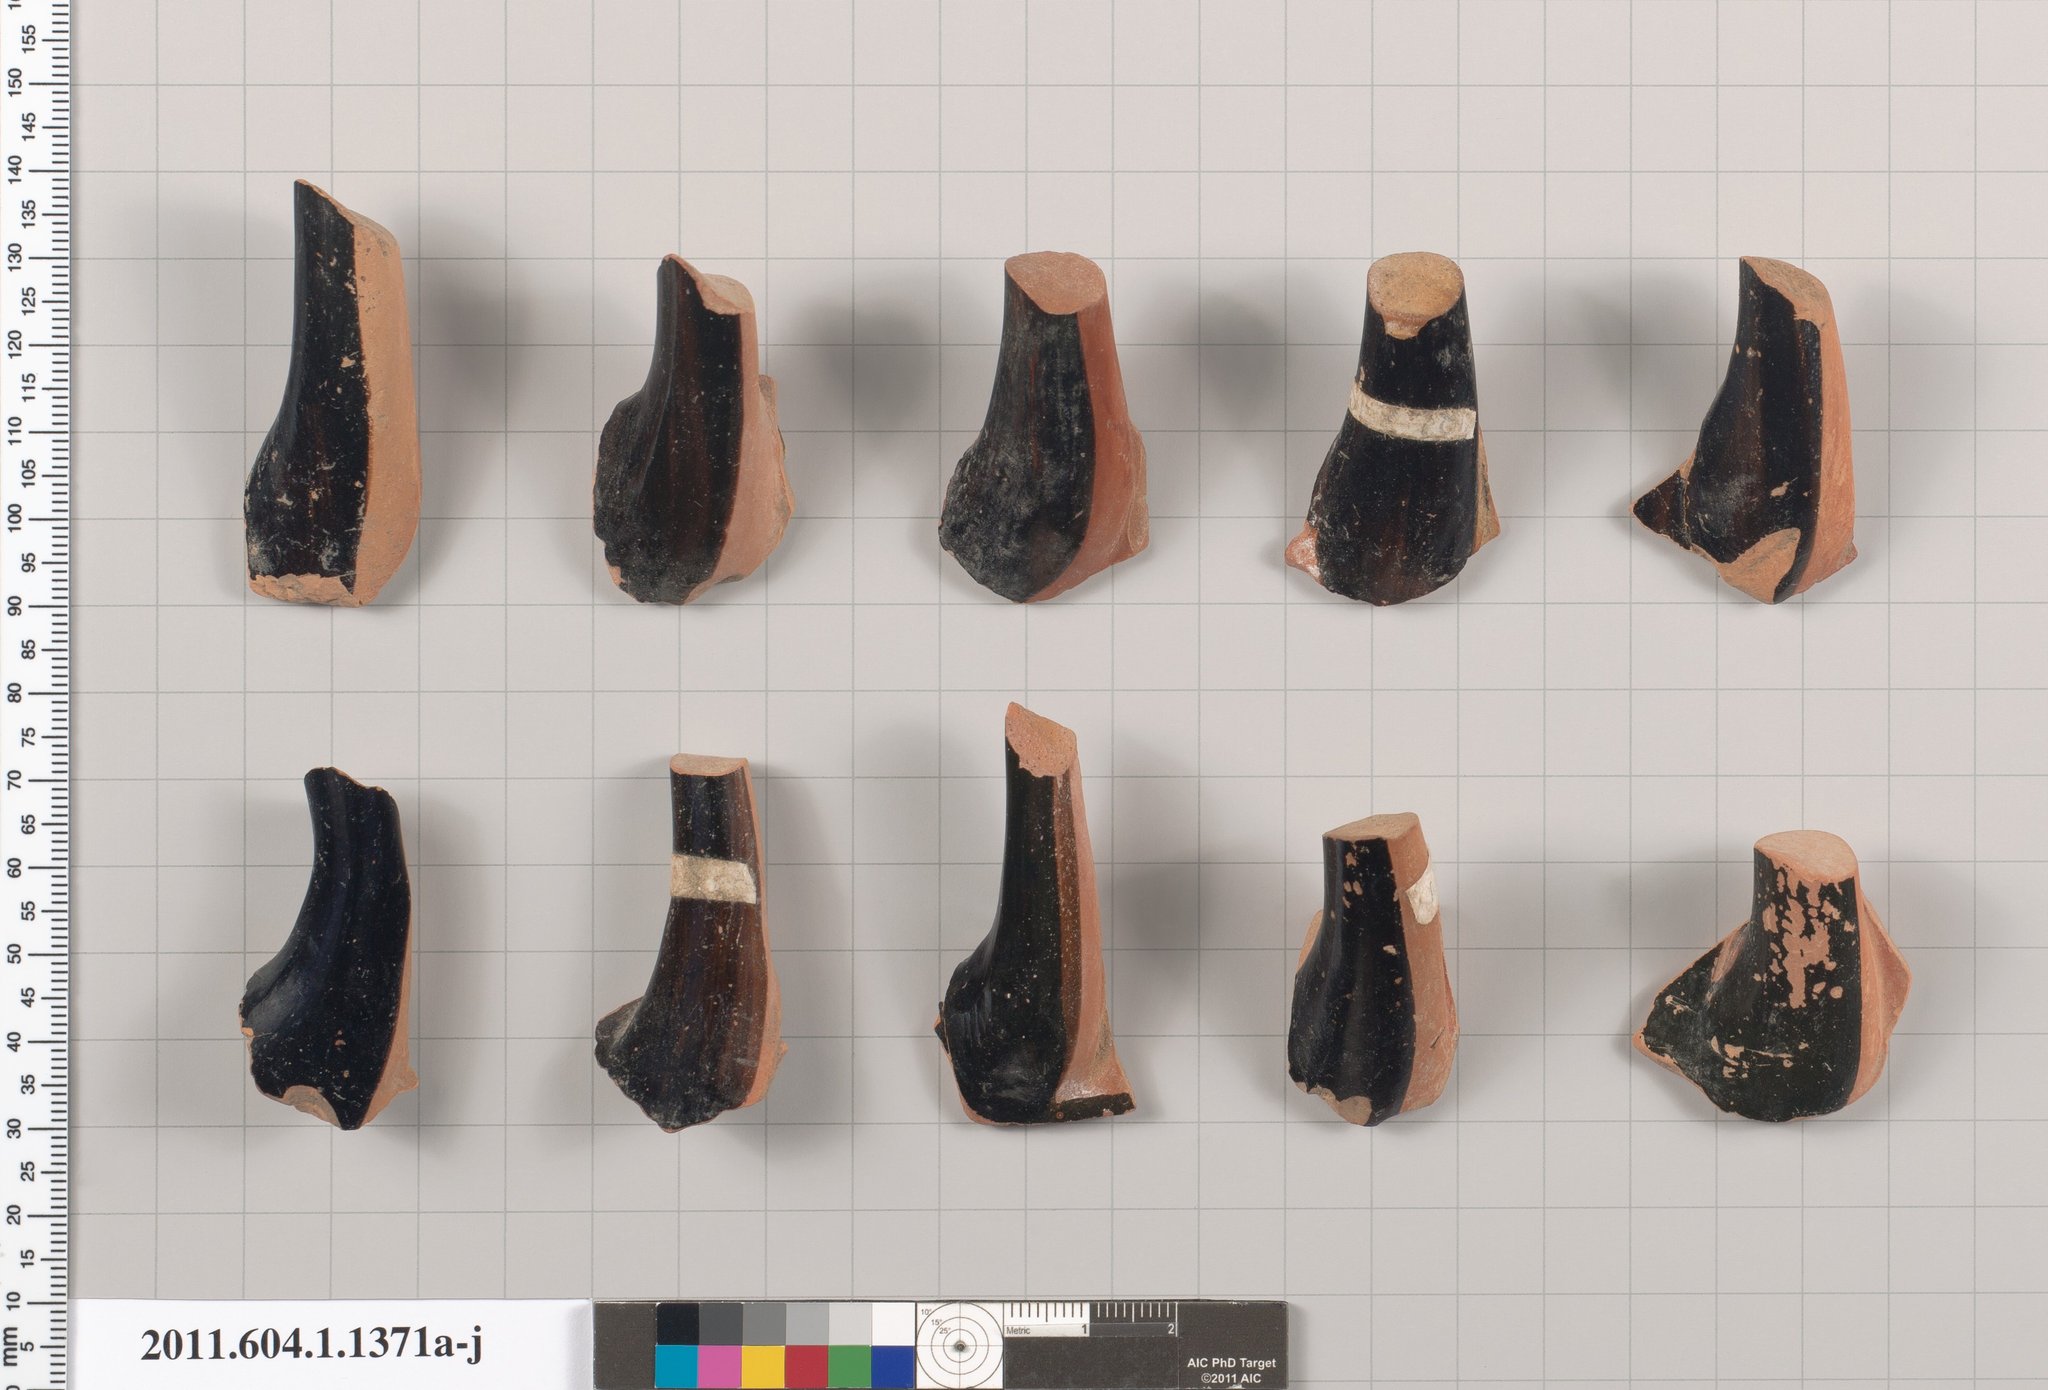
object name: kylix fragment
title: Terracotta fragments of kylikes (drinking cups)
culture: greek, attic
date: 500-401 BCE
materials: terracotta